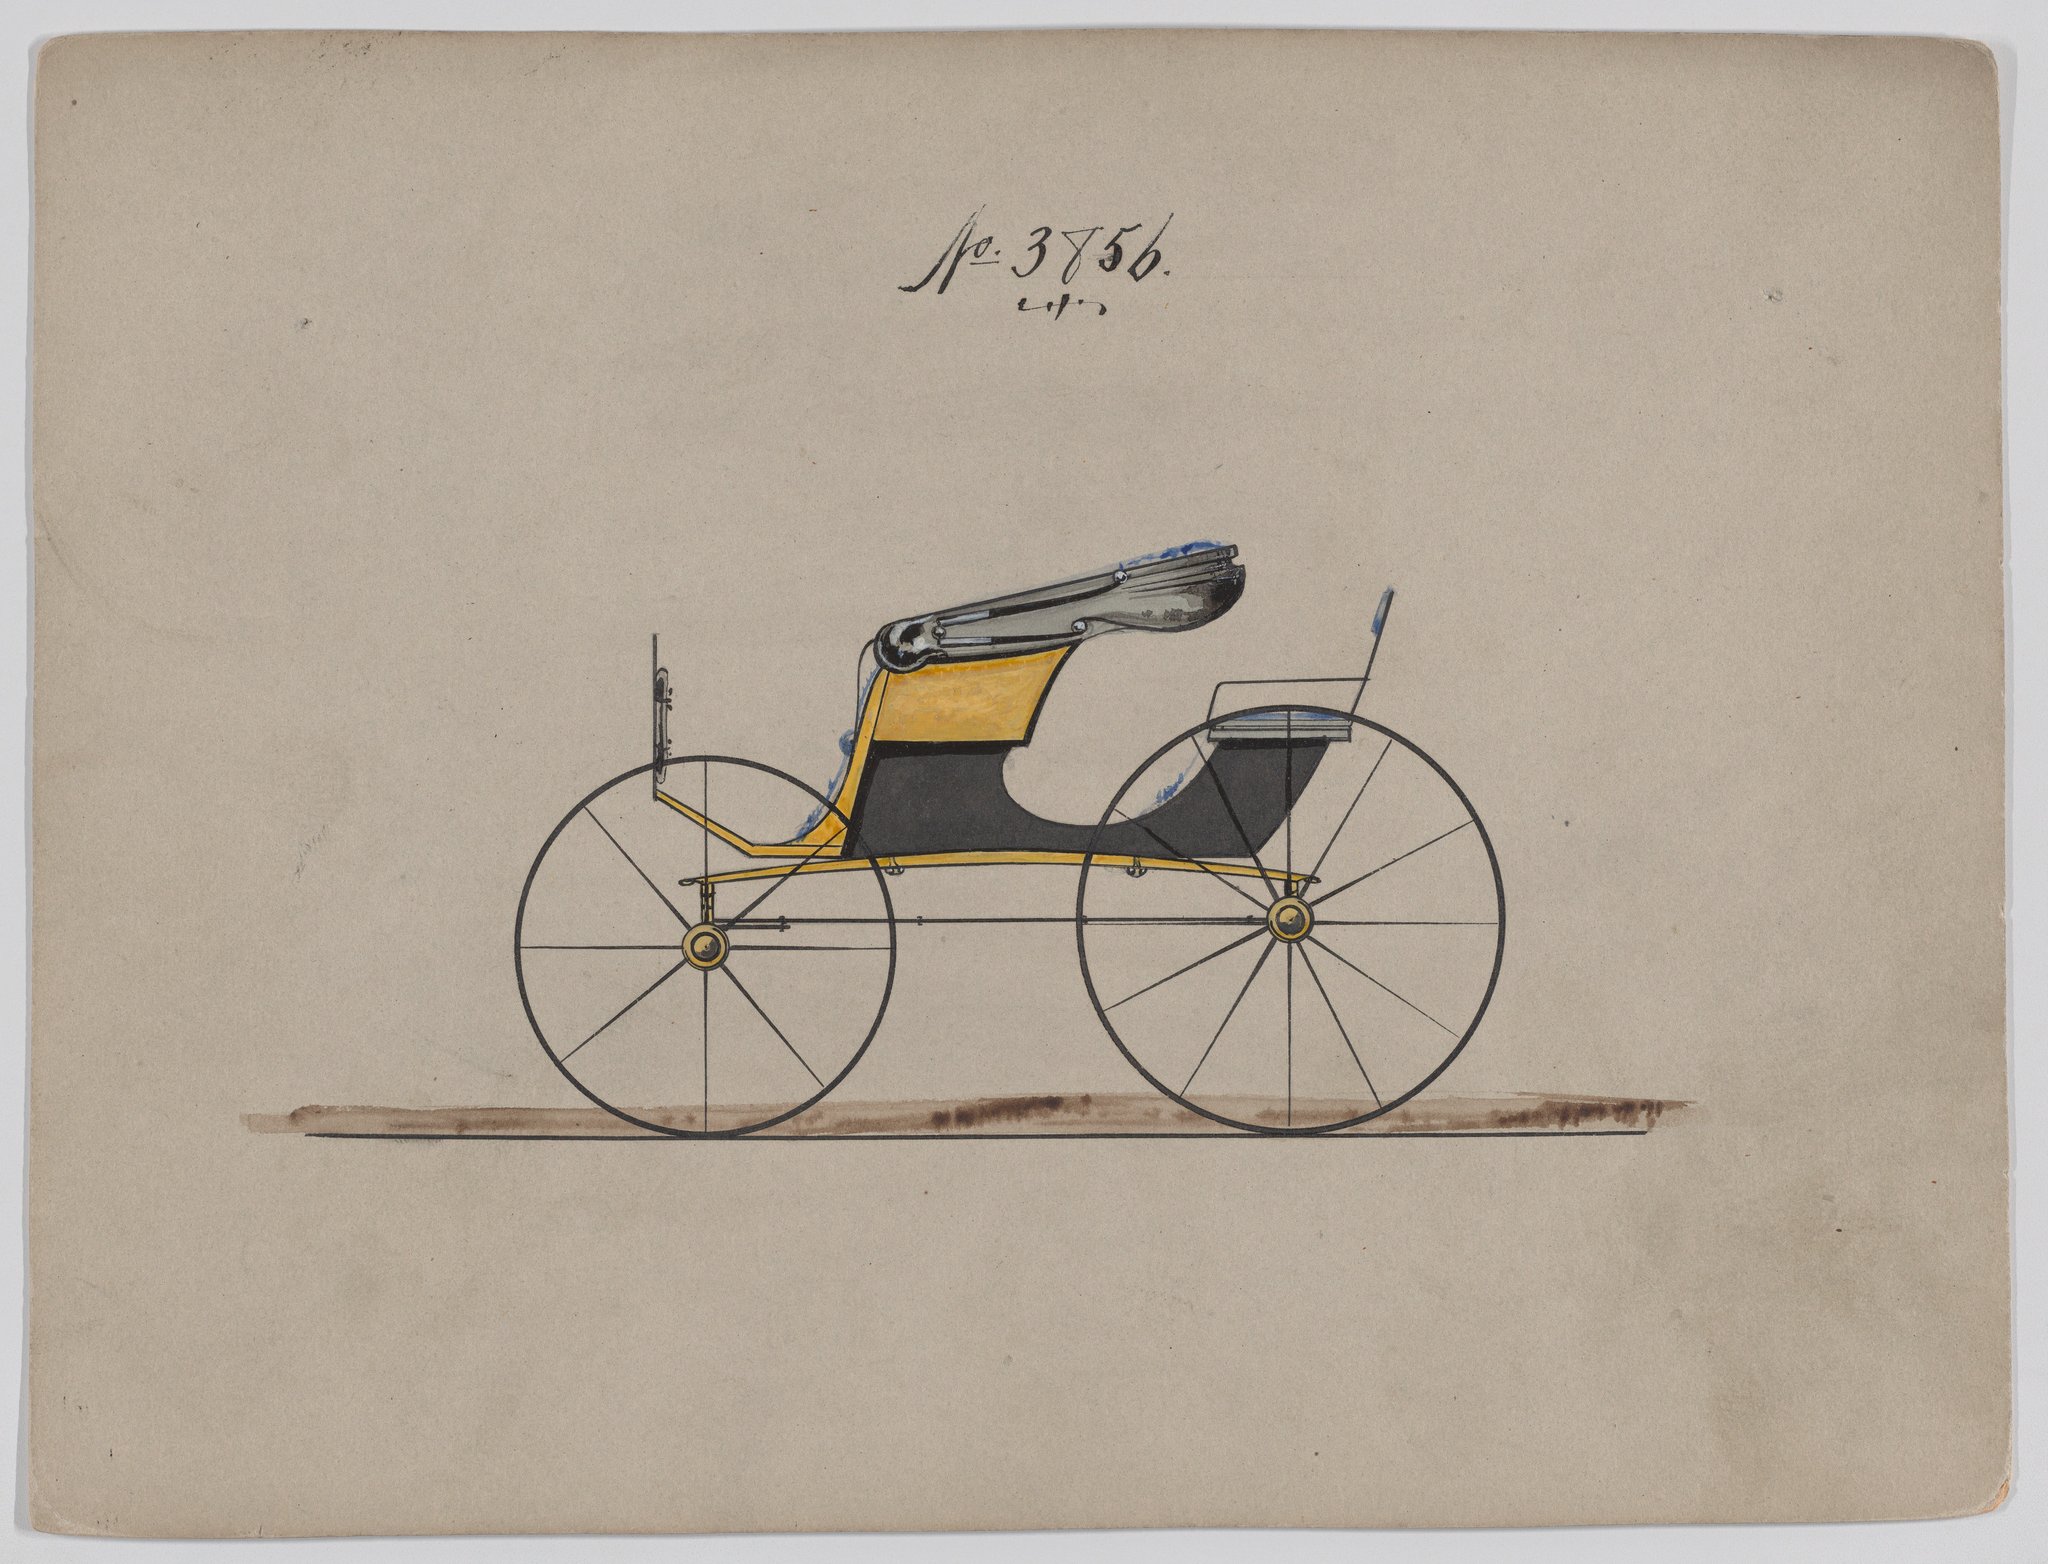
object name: drawing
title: Design for Side Bar Phaeton, no. 3856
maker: brewster & co.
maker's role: manufacturer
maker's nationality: american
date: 1883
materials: gouache, gum arabic, ink, watercolor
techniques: pen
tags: carriages